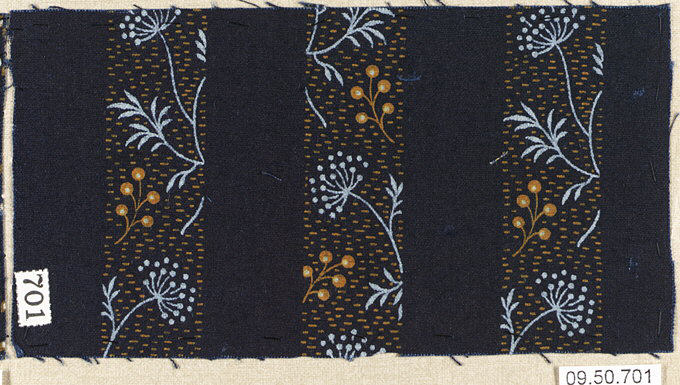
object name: piece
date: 1801-1900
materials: cotton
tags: flowers,leaves